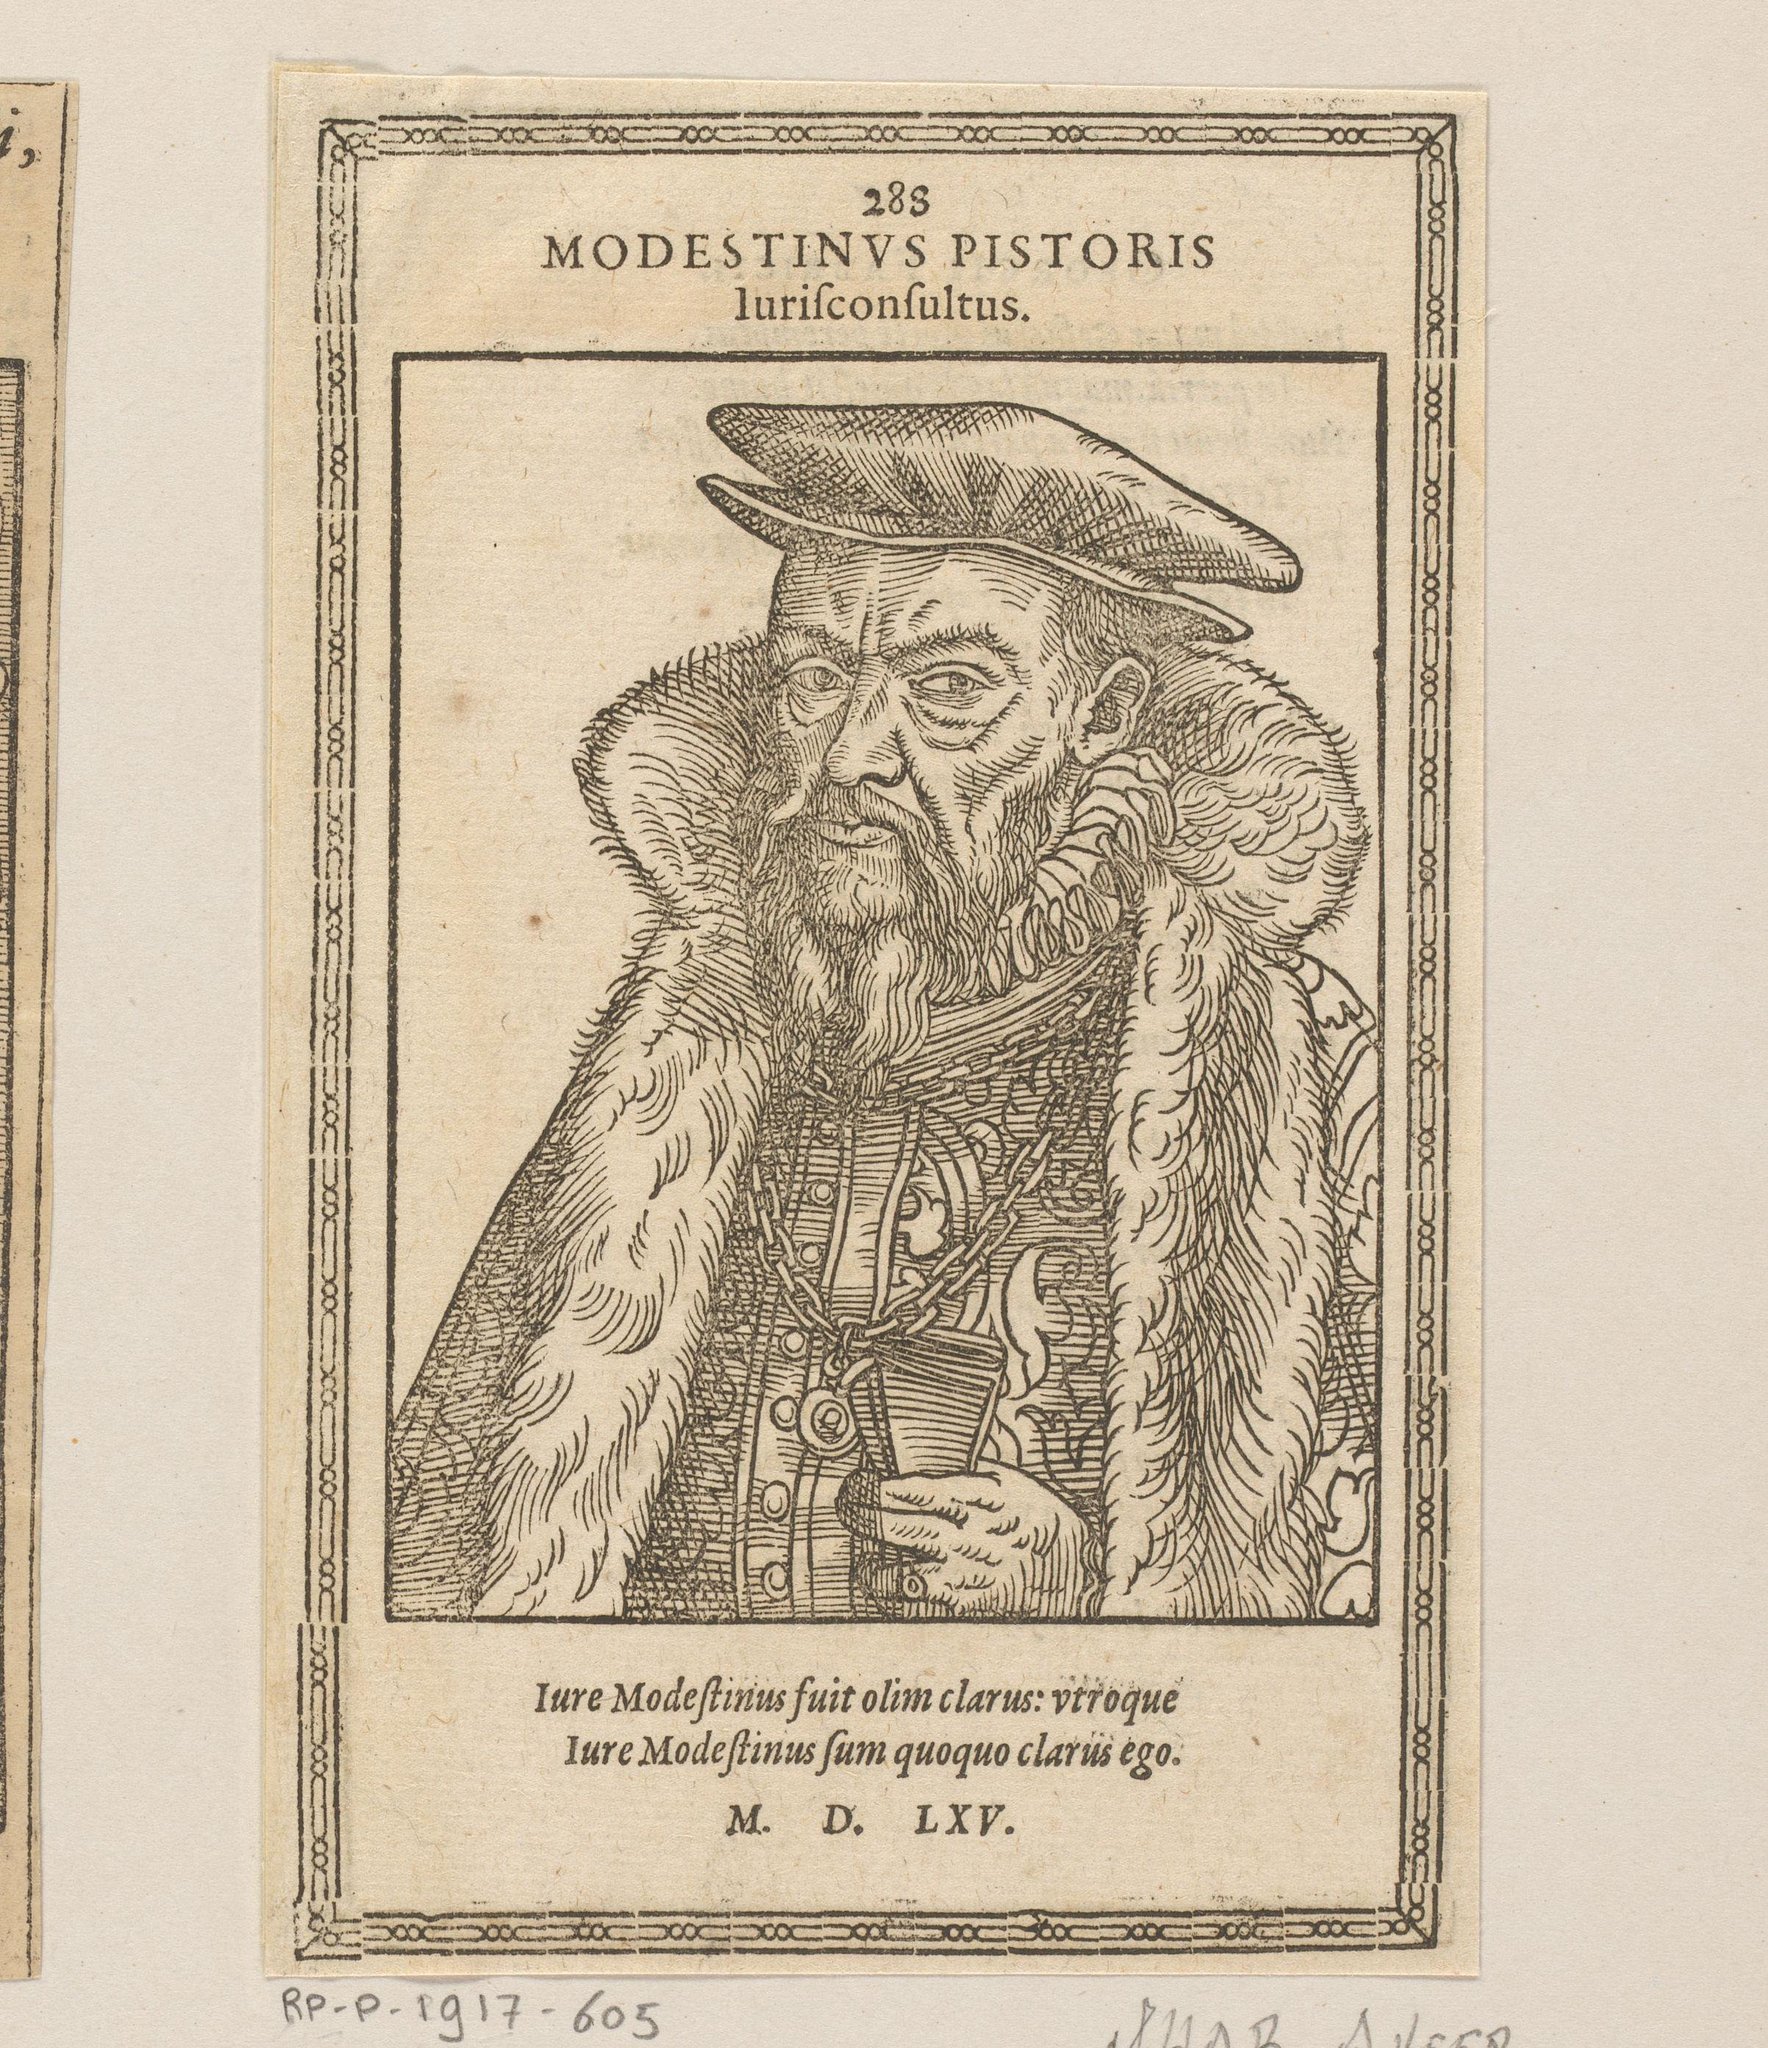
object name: book illustration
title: Portret van Modestinus Pistoris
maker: bernhard jobin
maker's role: printer, publisher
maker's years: 1545-1593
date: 1590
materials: paper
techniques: letterpress printing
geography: straatsburg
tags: historical persons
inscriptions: collector's mark: Lugt 2228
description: Prent uit: Reusner, Nikolaus. Icones sive imagines virorum literis illustrium (...). Straatsburg: Bernhard Jobin, 1590, p. 288. Prent voor het eerst verschenen in de eerste editie van 1587. Prent ook gebruikt in latere publicaties.